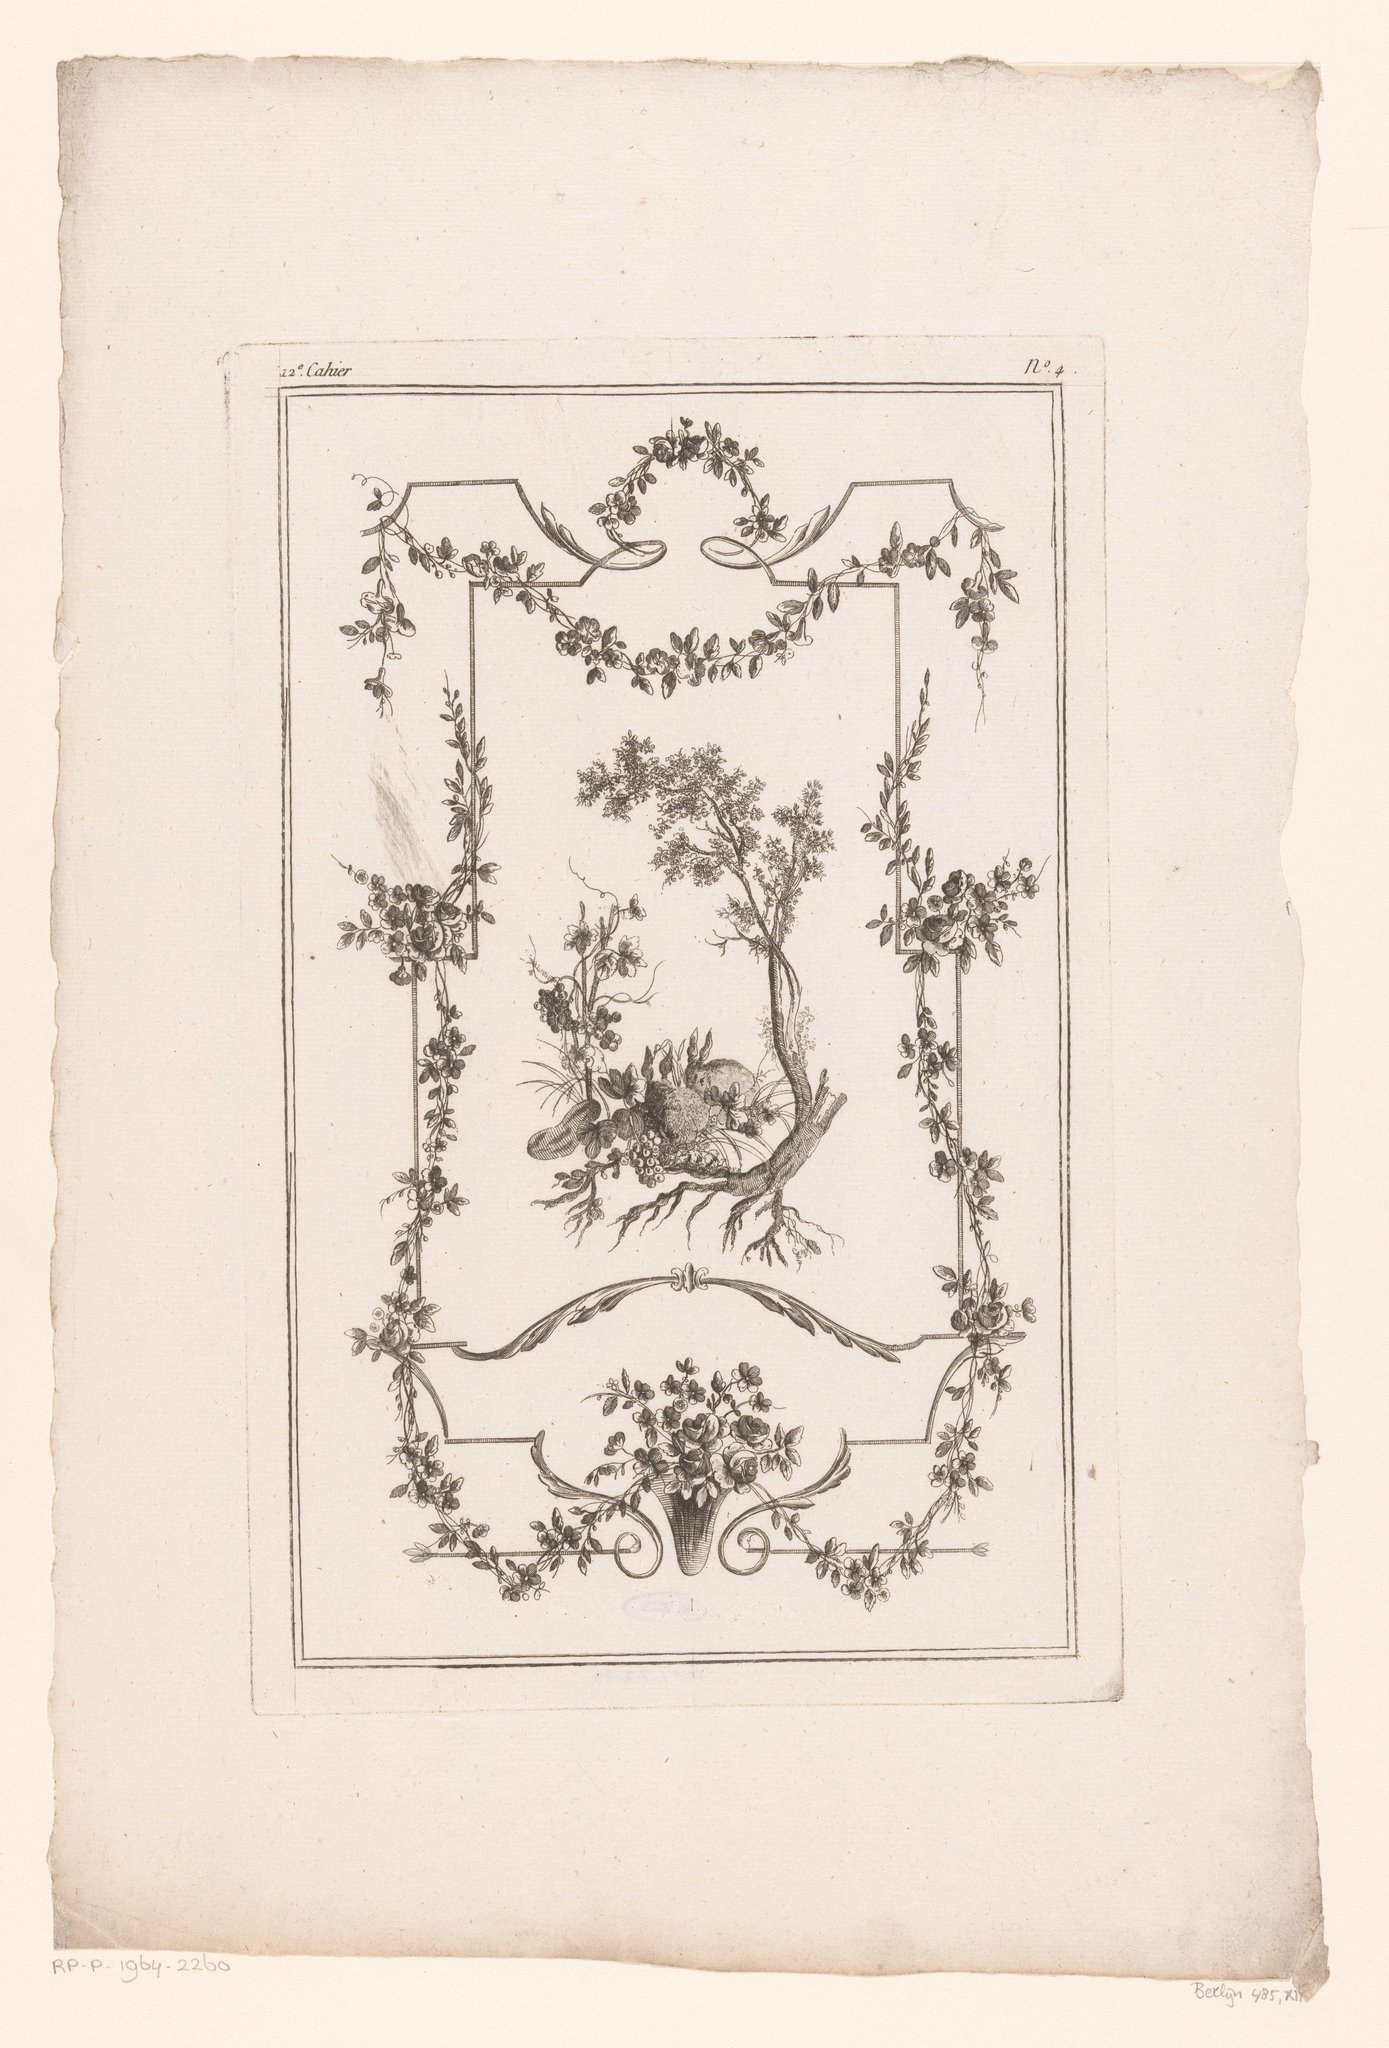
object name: ornament print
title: Paneel met konijnen in landschap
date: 1777-1779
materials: paper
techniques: etching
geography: rouen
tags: landscapes, panelling, rodents: rabbit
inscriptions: collector's mark: Lugt 2228, collector's mark: Lugt 2760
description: Een paneel met omlijsting van bloemranken rondom twee konijnen in een landschap met fruit en een boom.